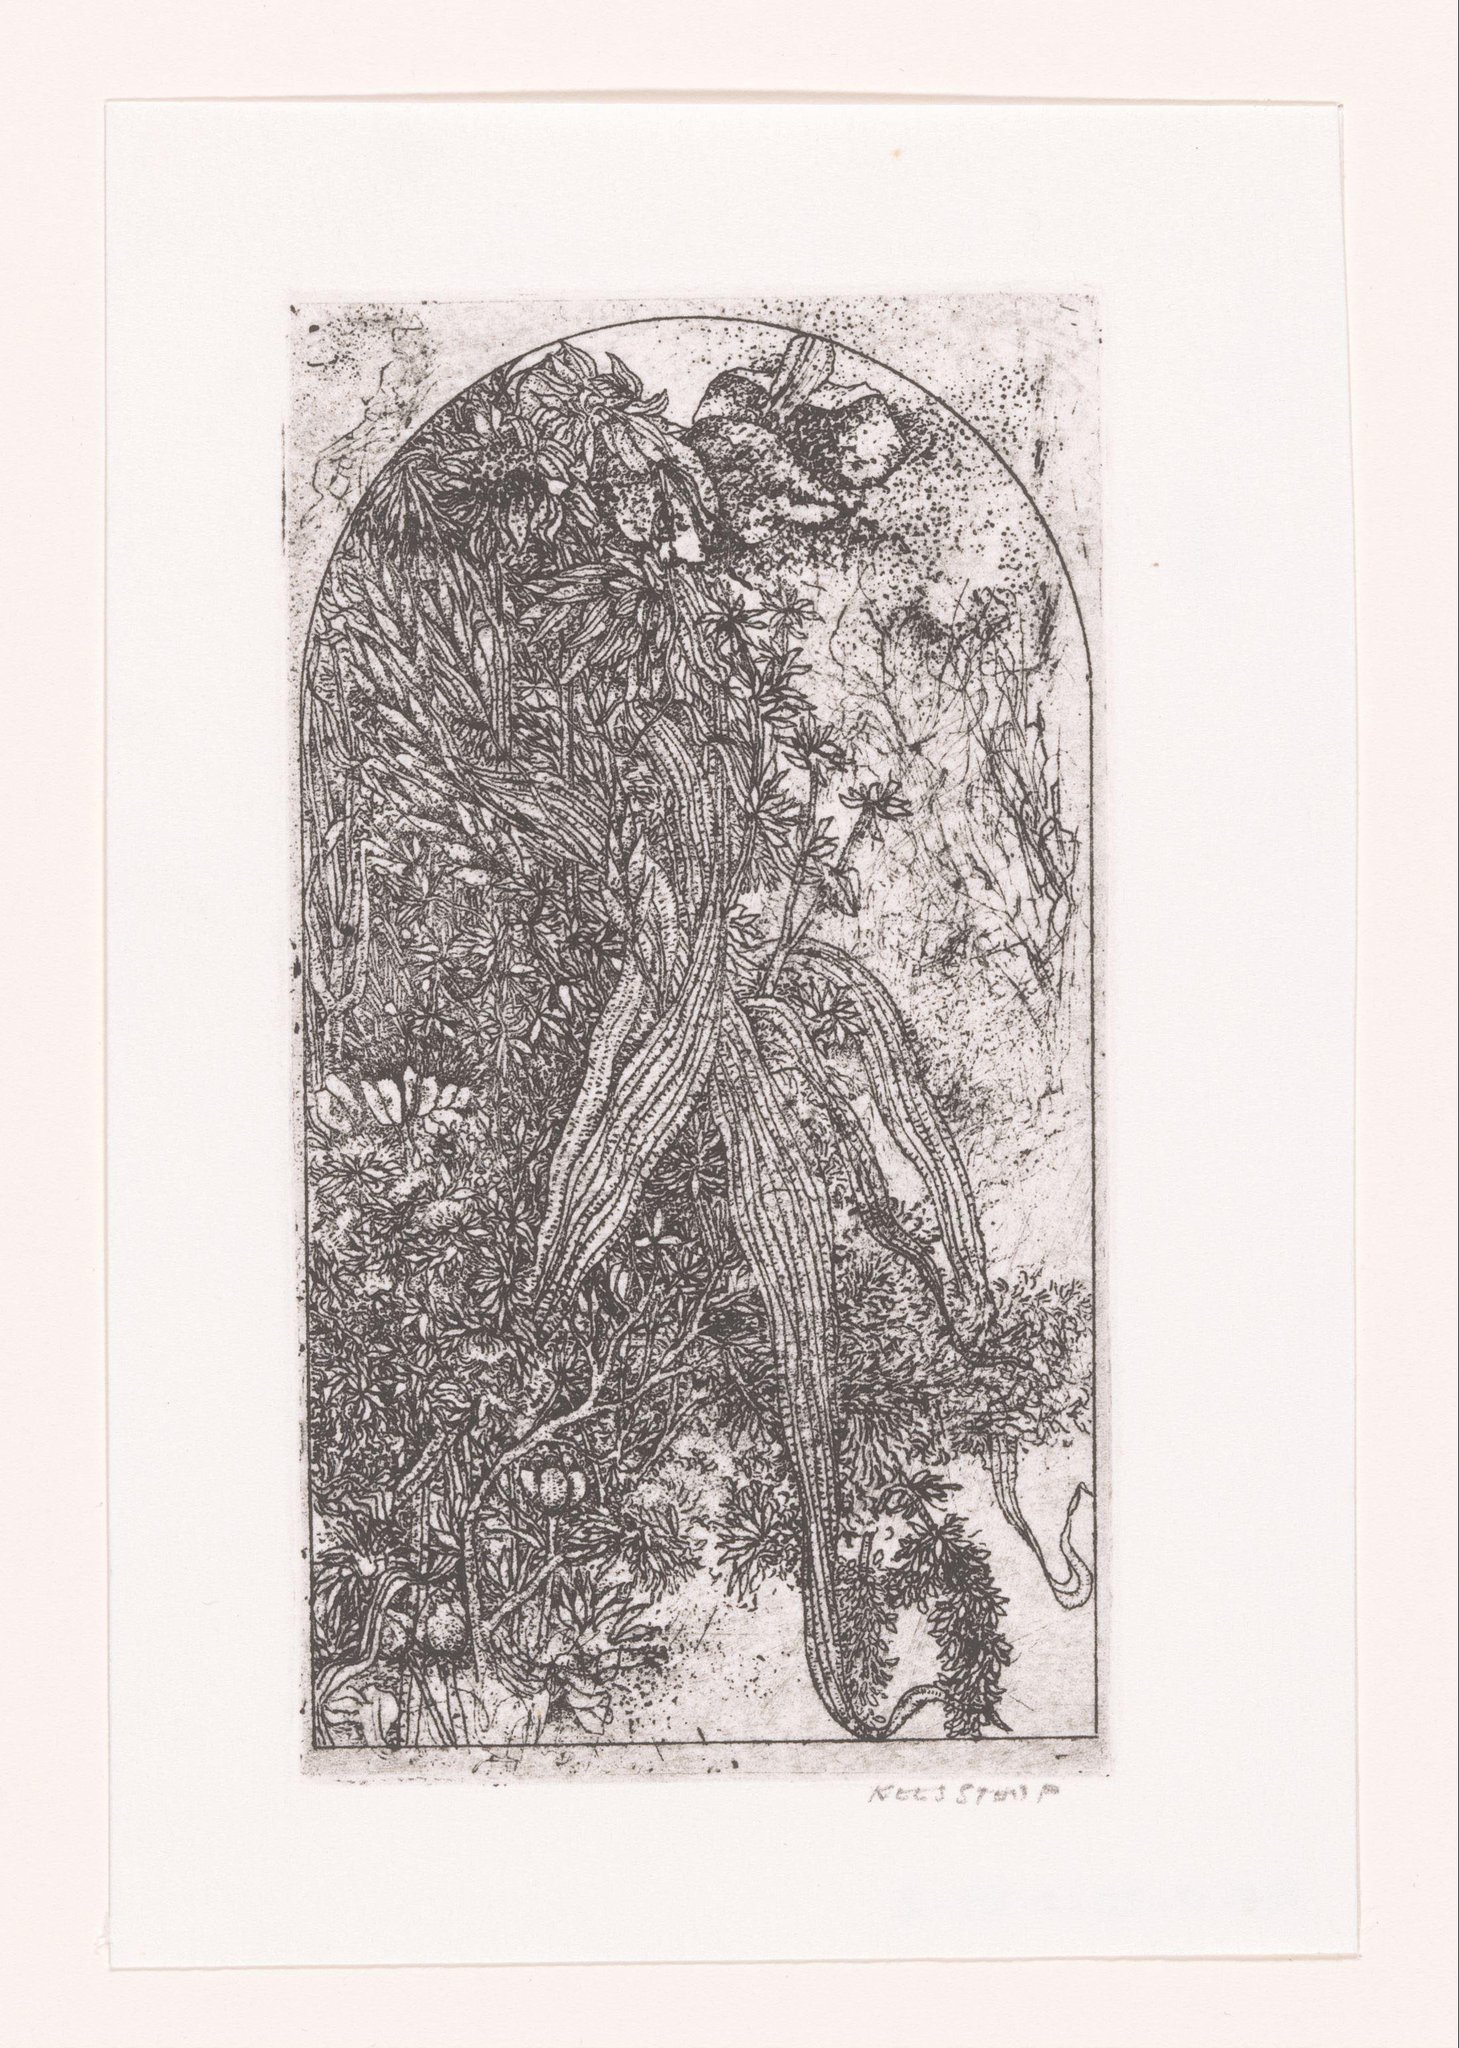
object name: print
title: Bloemen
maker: kees stoop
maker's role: draughtsman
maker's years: 1929-2019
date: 1944-1990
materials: paper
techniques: etching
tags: flowers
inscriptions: signature: ‘KEES STOOP’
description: Bloemen binnen rondboog, met lange neerhangende bladeren.